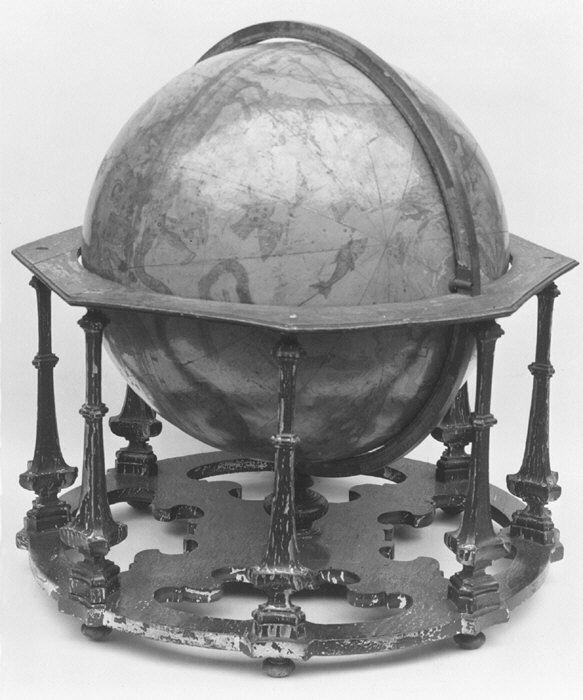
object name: celestial globe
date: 1695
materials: metal, paper, wood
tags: globes